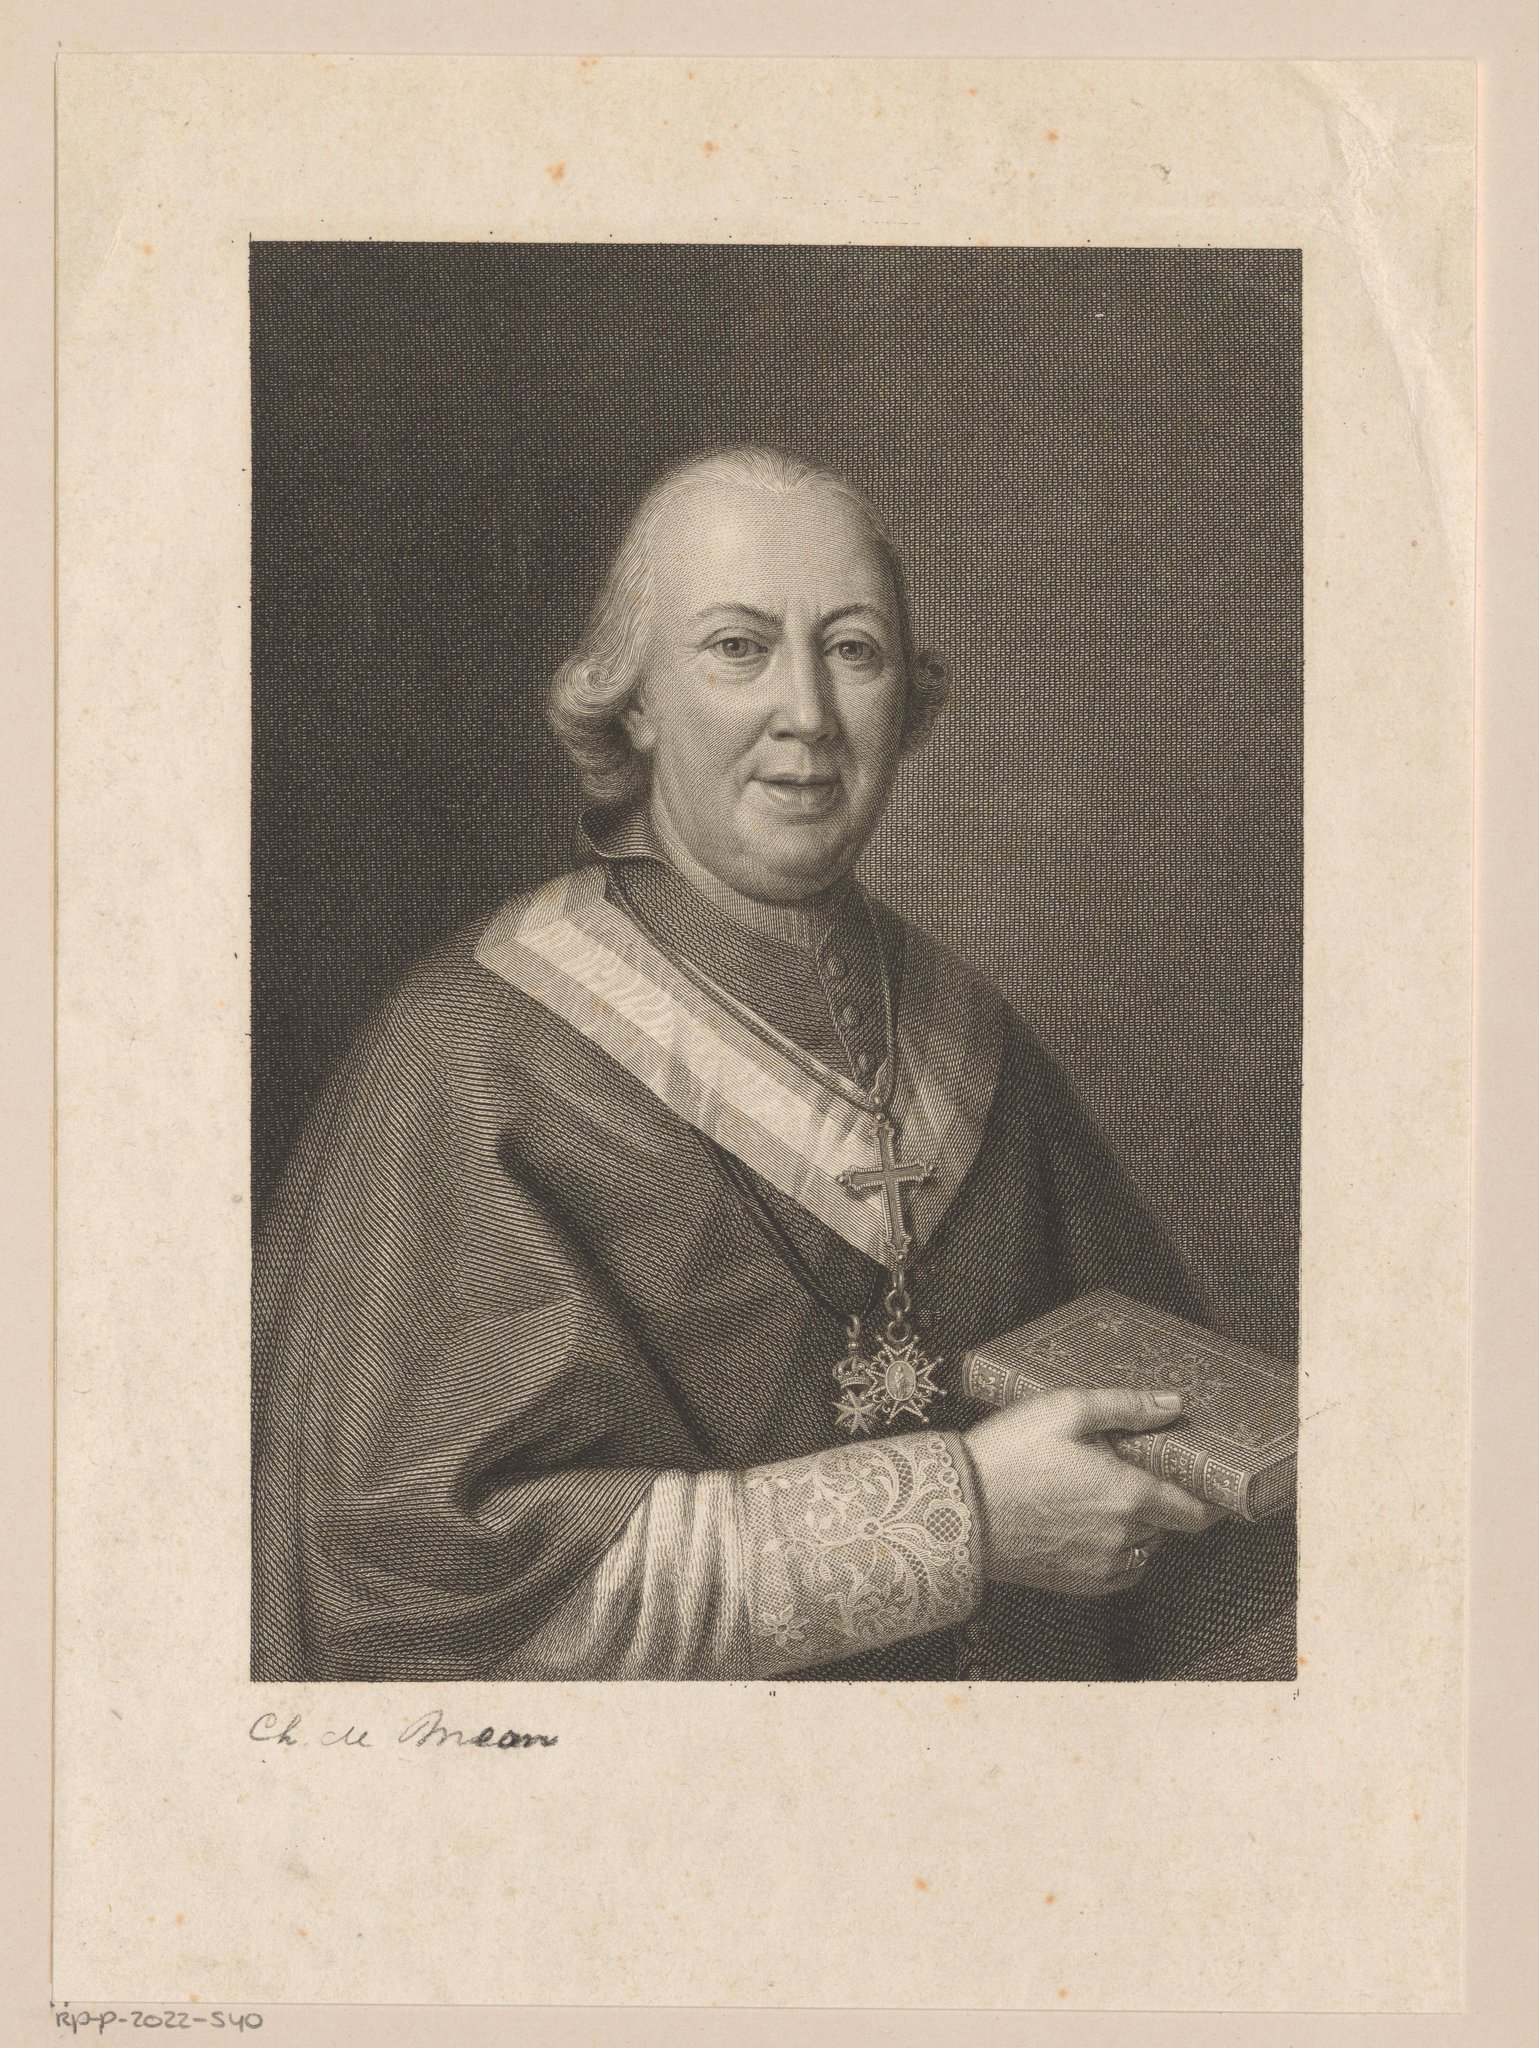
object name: print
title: Portret van Franciscus Antonius de Méan de Beaurieux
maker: Anonymous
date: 1785-1831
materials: paper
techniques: etching, roulette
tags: archbishop, bishop, etc. (roman catholic), historical persons